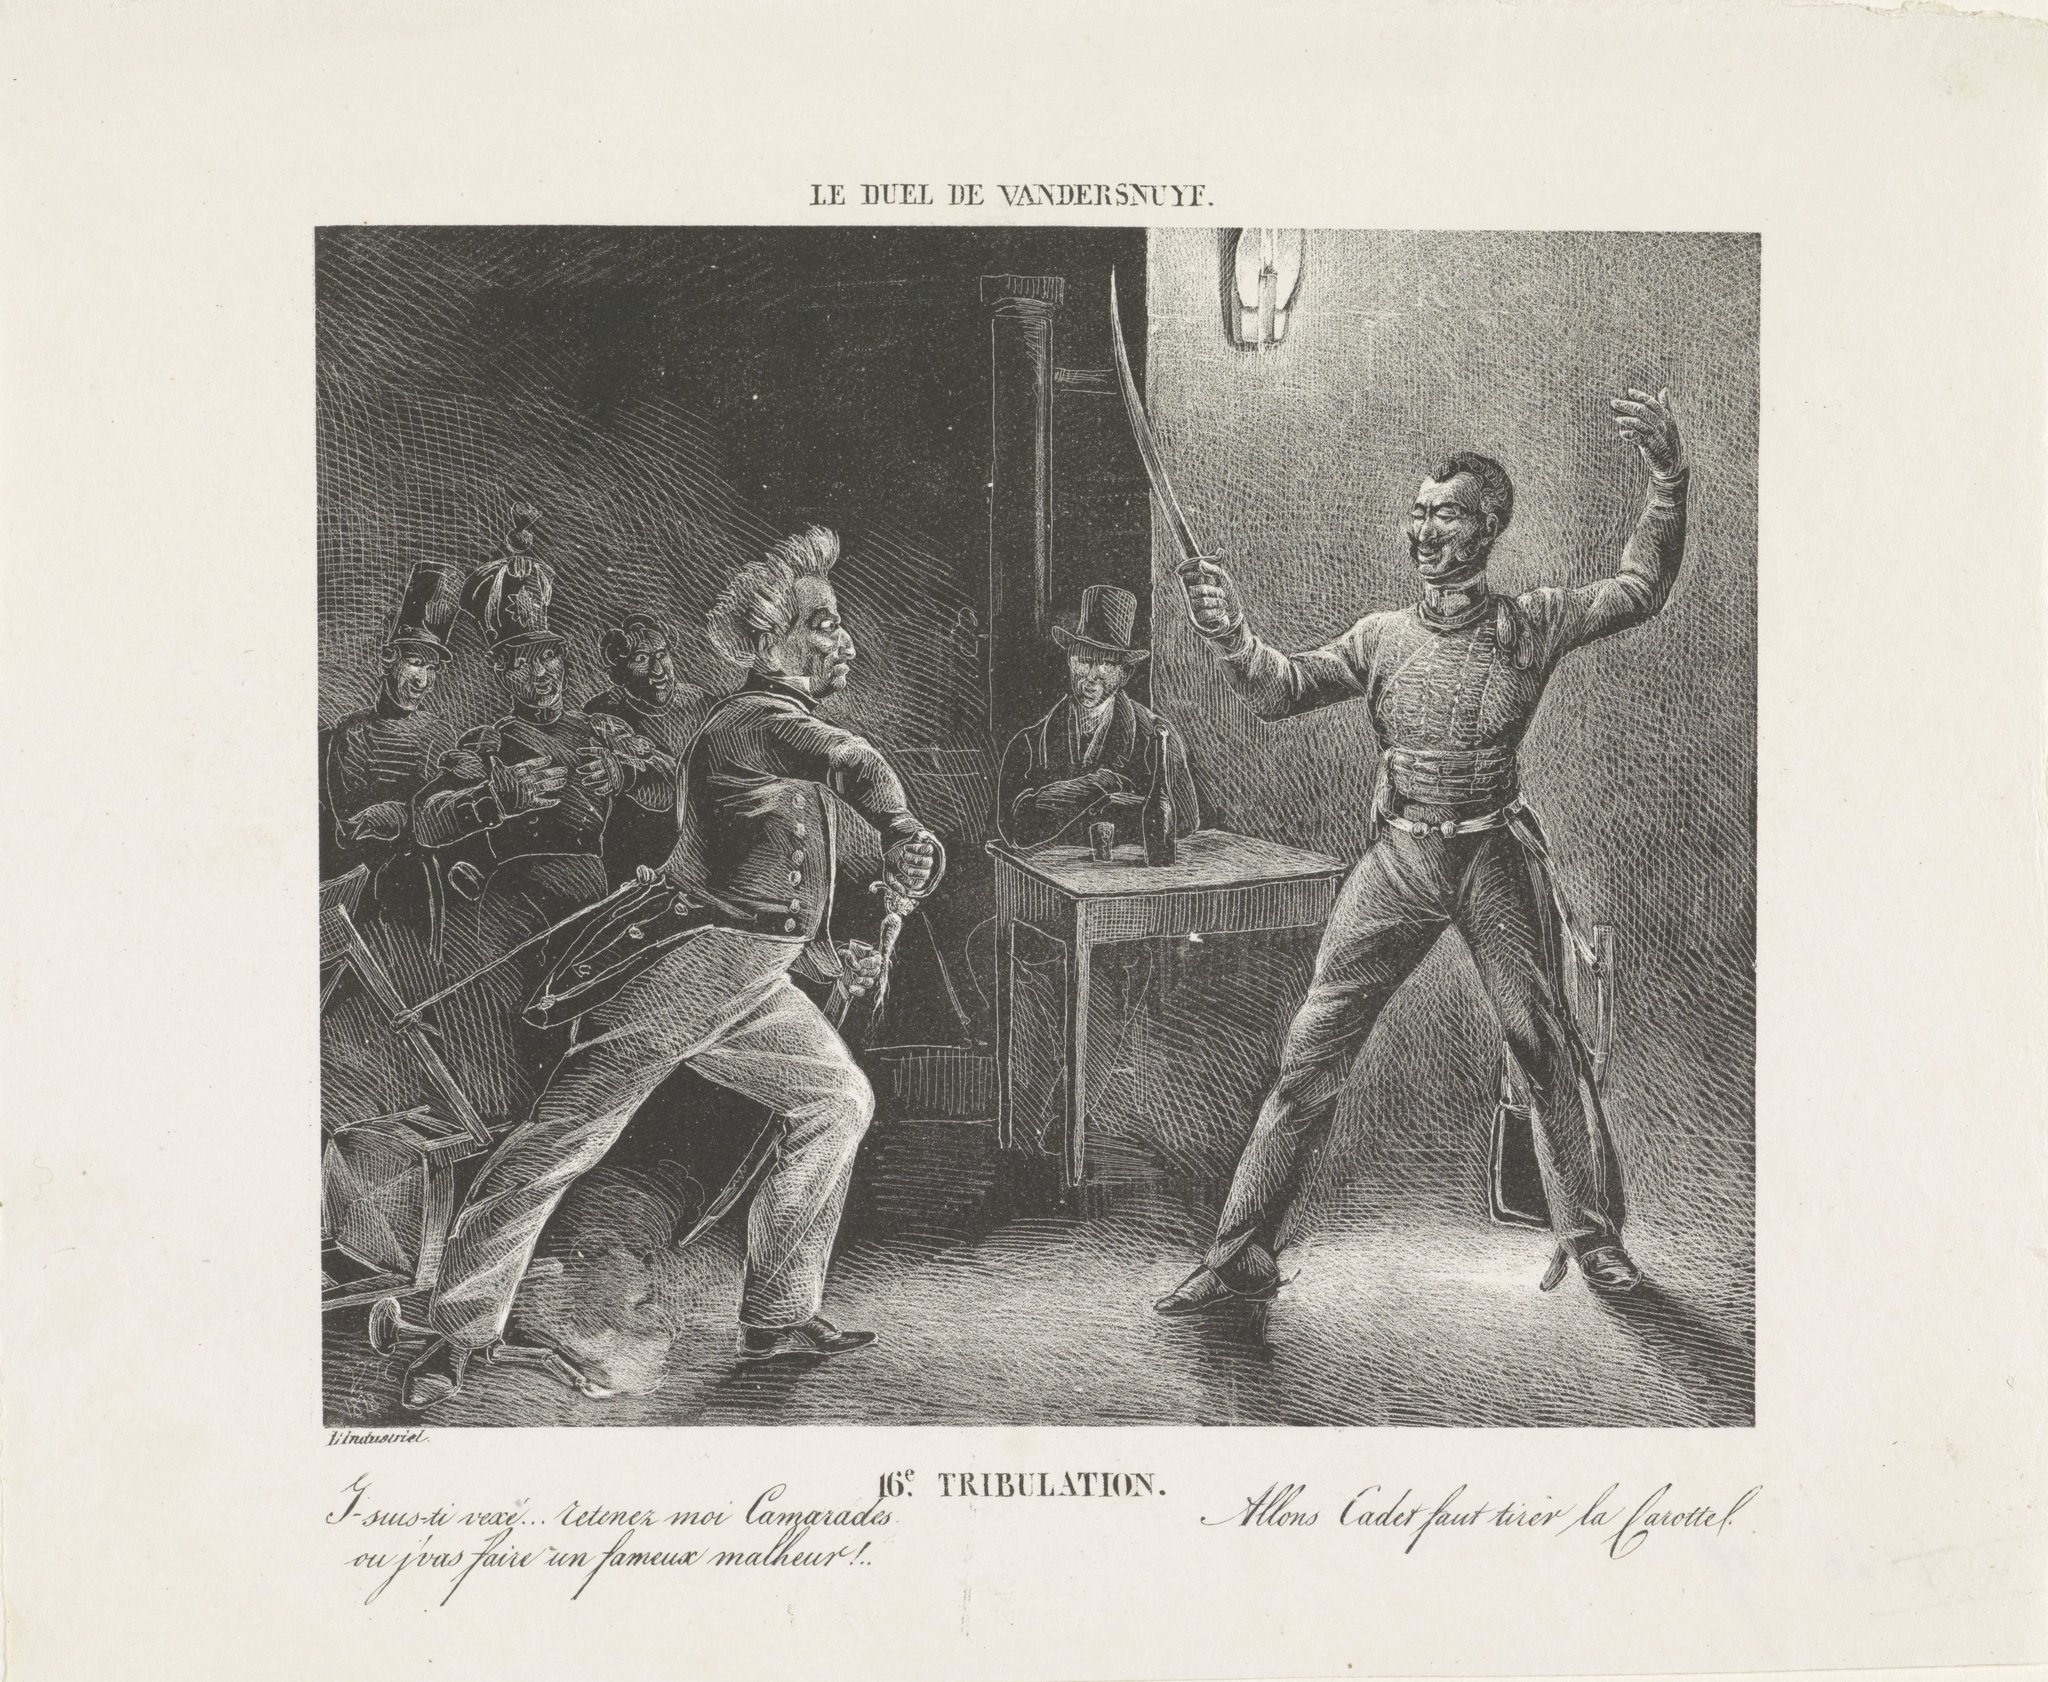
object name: print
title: Zestiende beproeving, 1828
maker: Anonymous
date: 1828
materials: paper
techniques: lithograph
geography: southern netherlands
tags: the soldier; the soldier's life, duelling, belgium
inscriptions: collector's mark: Lugt 2228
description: Duel tussen Van der Snuijff en een huzaar in een kroeg. Van der Snuijff trekt een wortel in plaats van zijn sabel en zijn jasje is aan het tafeltje geknoopt. Onderdeel van een serie van ca. 24 spotprenten uit 1828 op de wanverhoudingen binnen de Belgische schutterijen door de maatschappelijke ongelijkheid binnen het korps, na de reorganisatie ingevoerd op 11 april 1827.